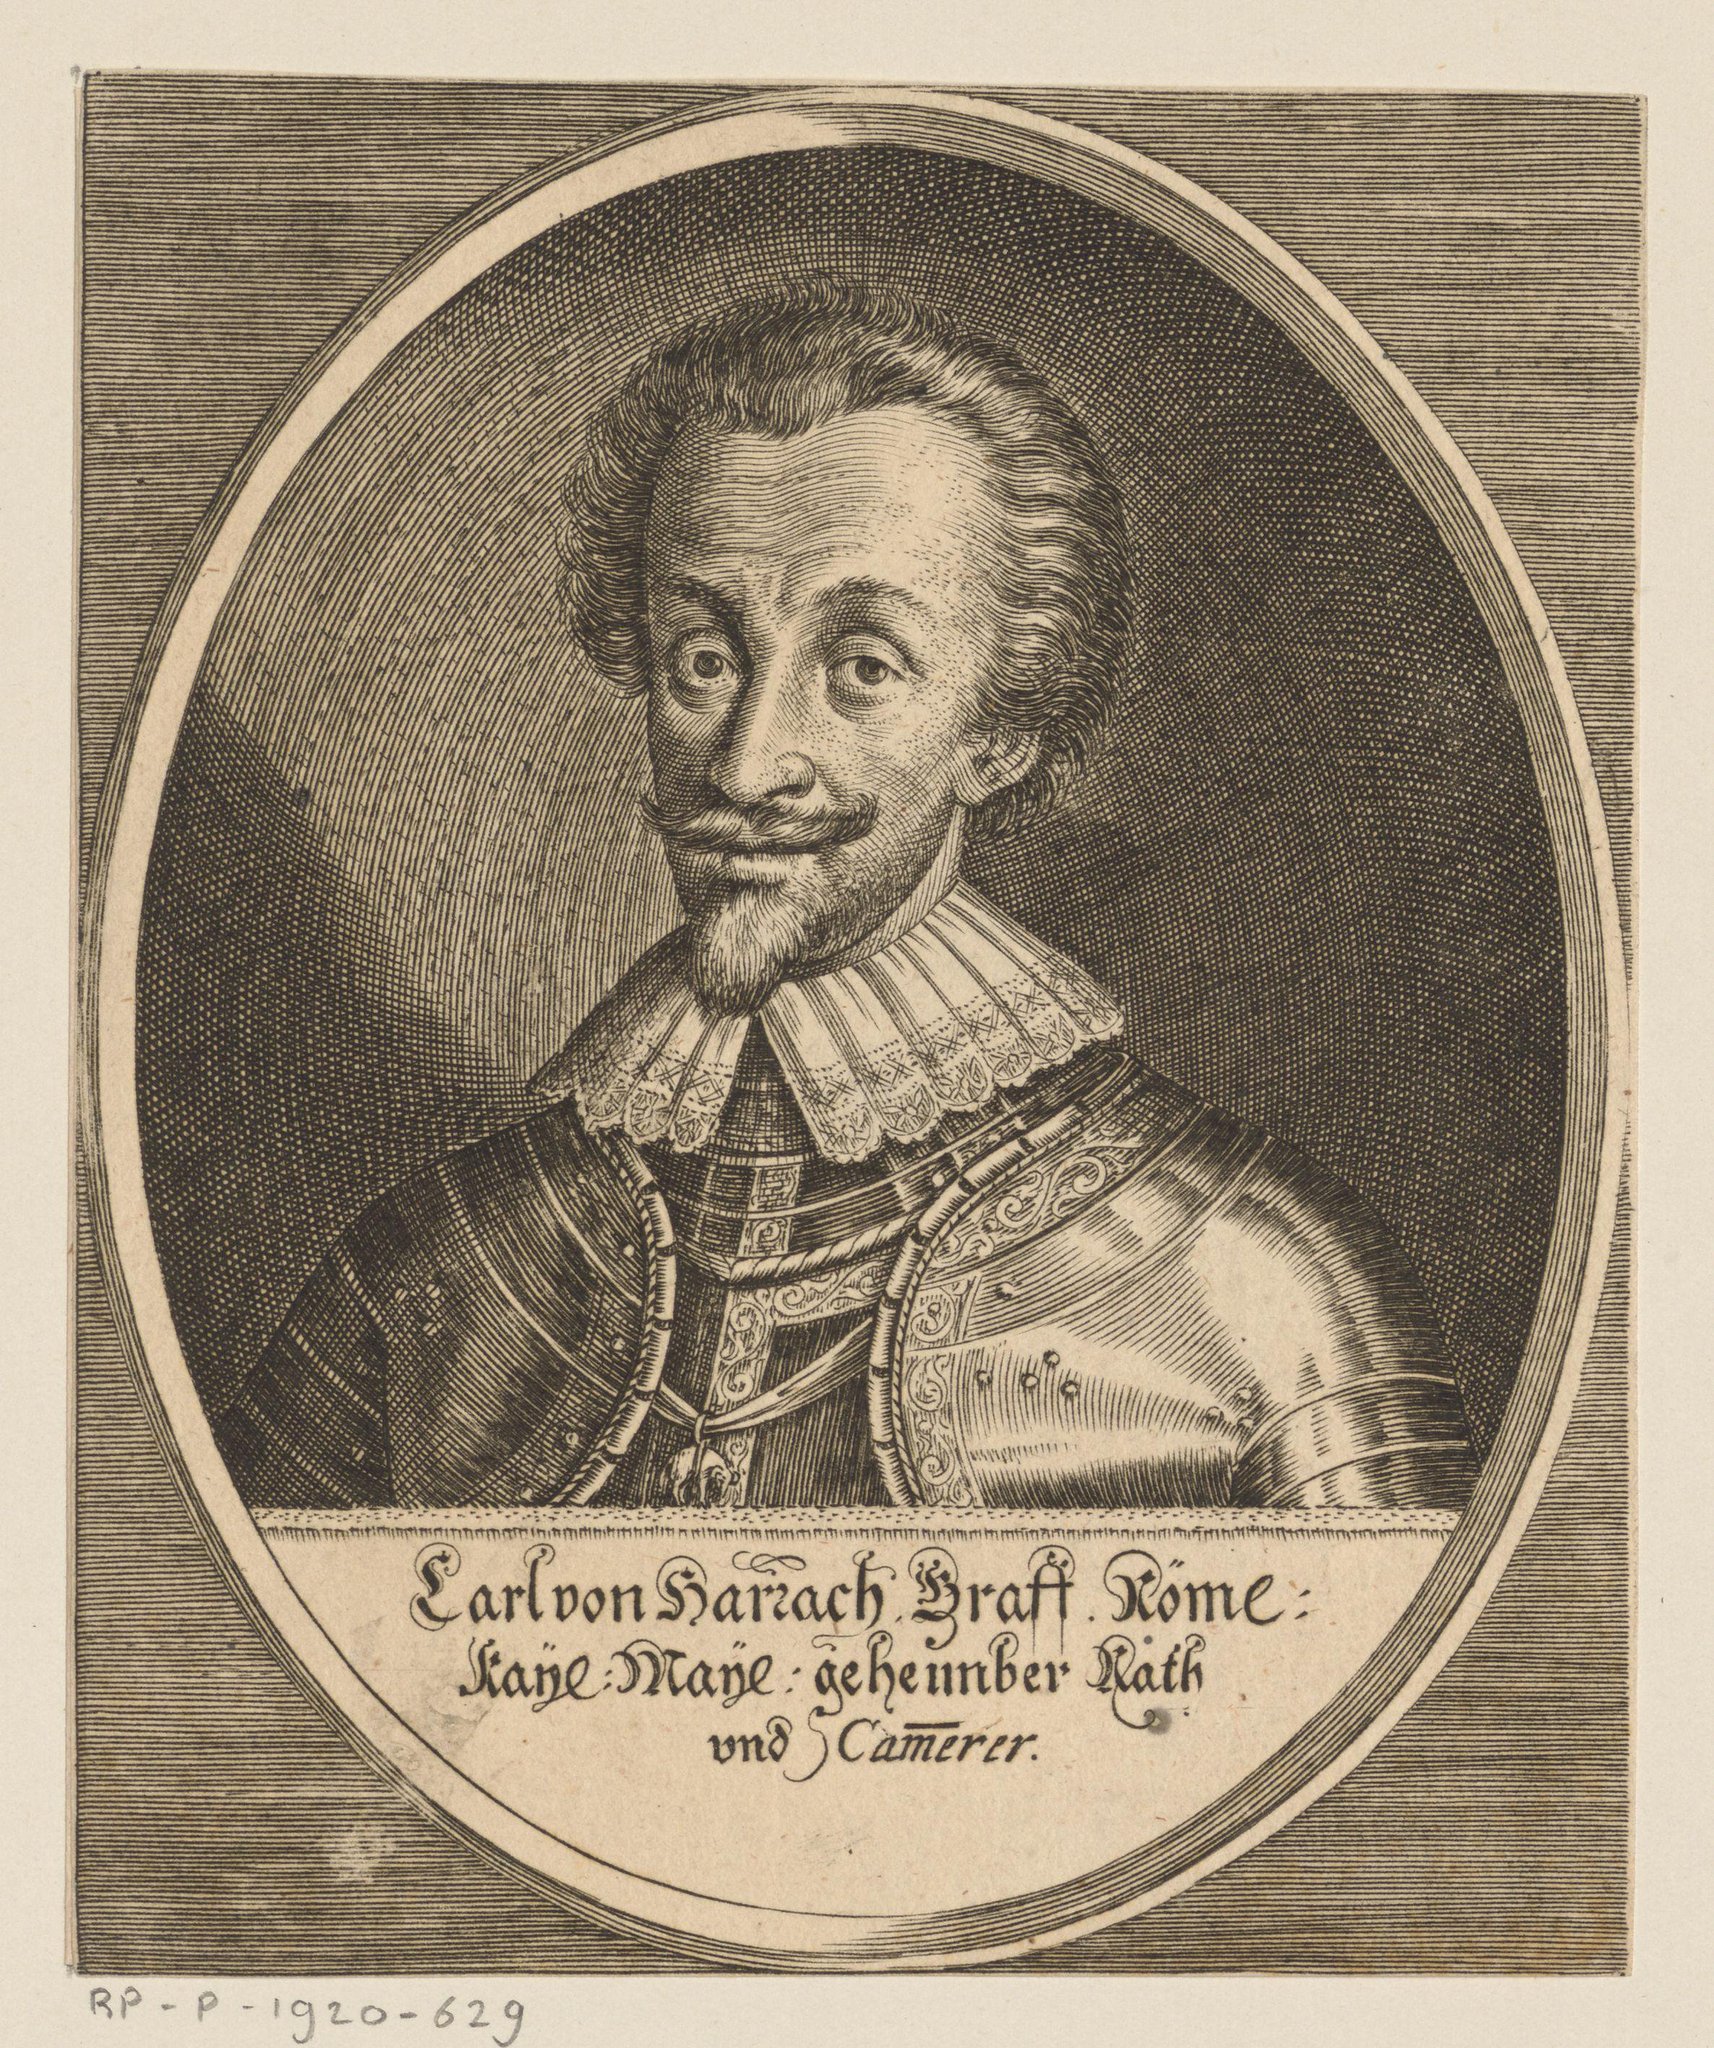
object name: print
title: Portret van Karl von Harrach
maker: Anonymous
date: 1650-1699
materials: paper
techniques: engraving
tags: earl, armour, historical persons, knighthood order of the golden fleece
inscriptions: collector's mark: Lugt 2228